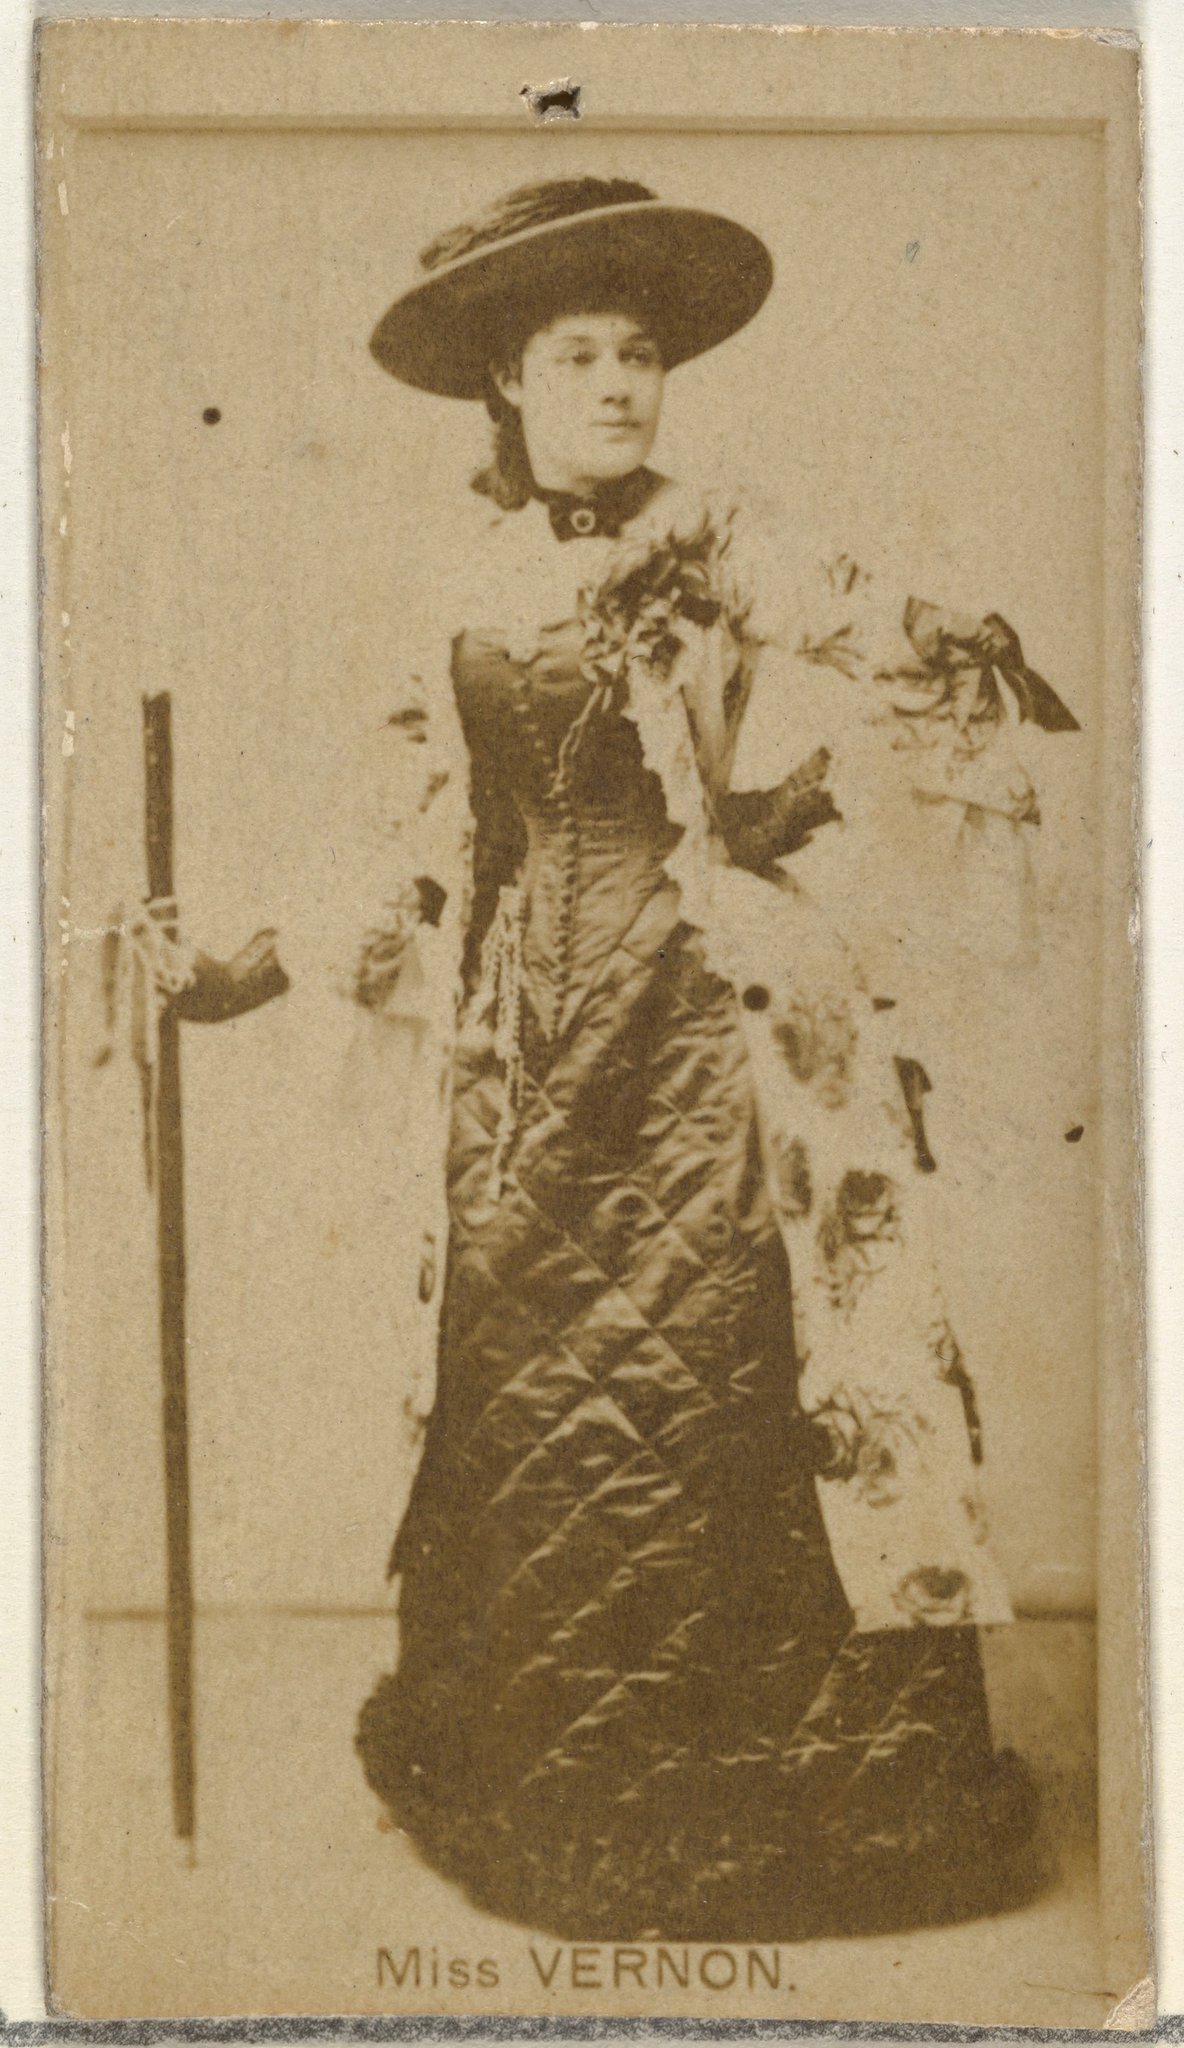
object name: photograph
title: Miss Vernon, from the Actors and Actresses series (N145-8) issued by Duke Sons & Co. to promote Duke Cigarettes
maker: w. duke, sons & co.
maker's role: publisher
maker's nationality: american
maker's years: 1870-1920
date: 1891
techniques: albumen silver print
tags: portraits,women,actresses